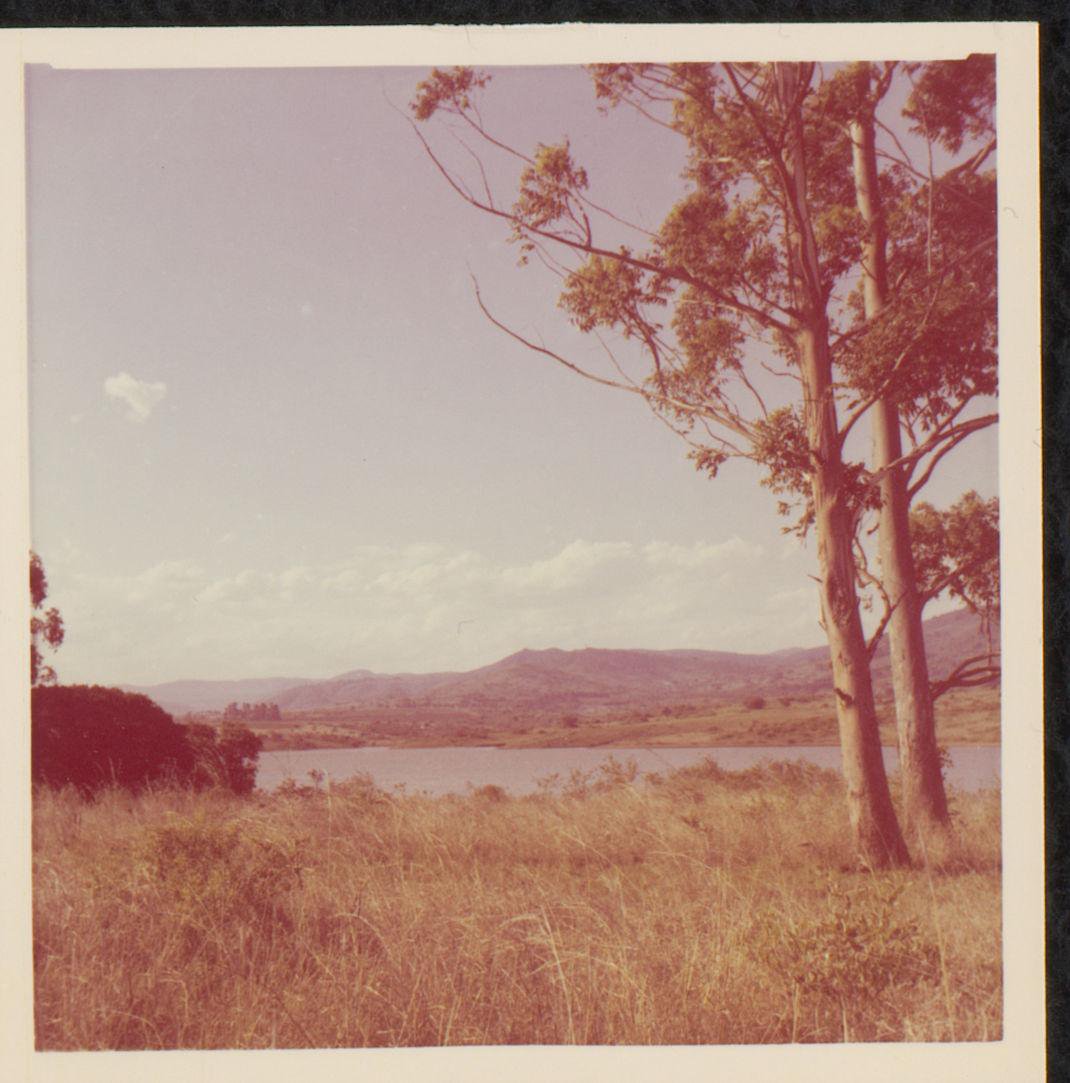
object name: photograph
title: Boslandschap, mogelijk in Zuid-Afrika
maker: willem jacob van den berg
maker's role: boer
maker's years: 1902-1983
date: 1967-1971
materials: paper, cardboard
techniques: chromogenic print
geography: south africa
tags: jungle